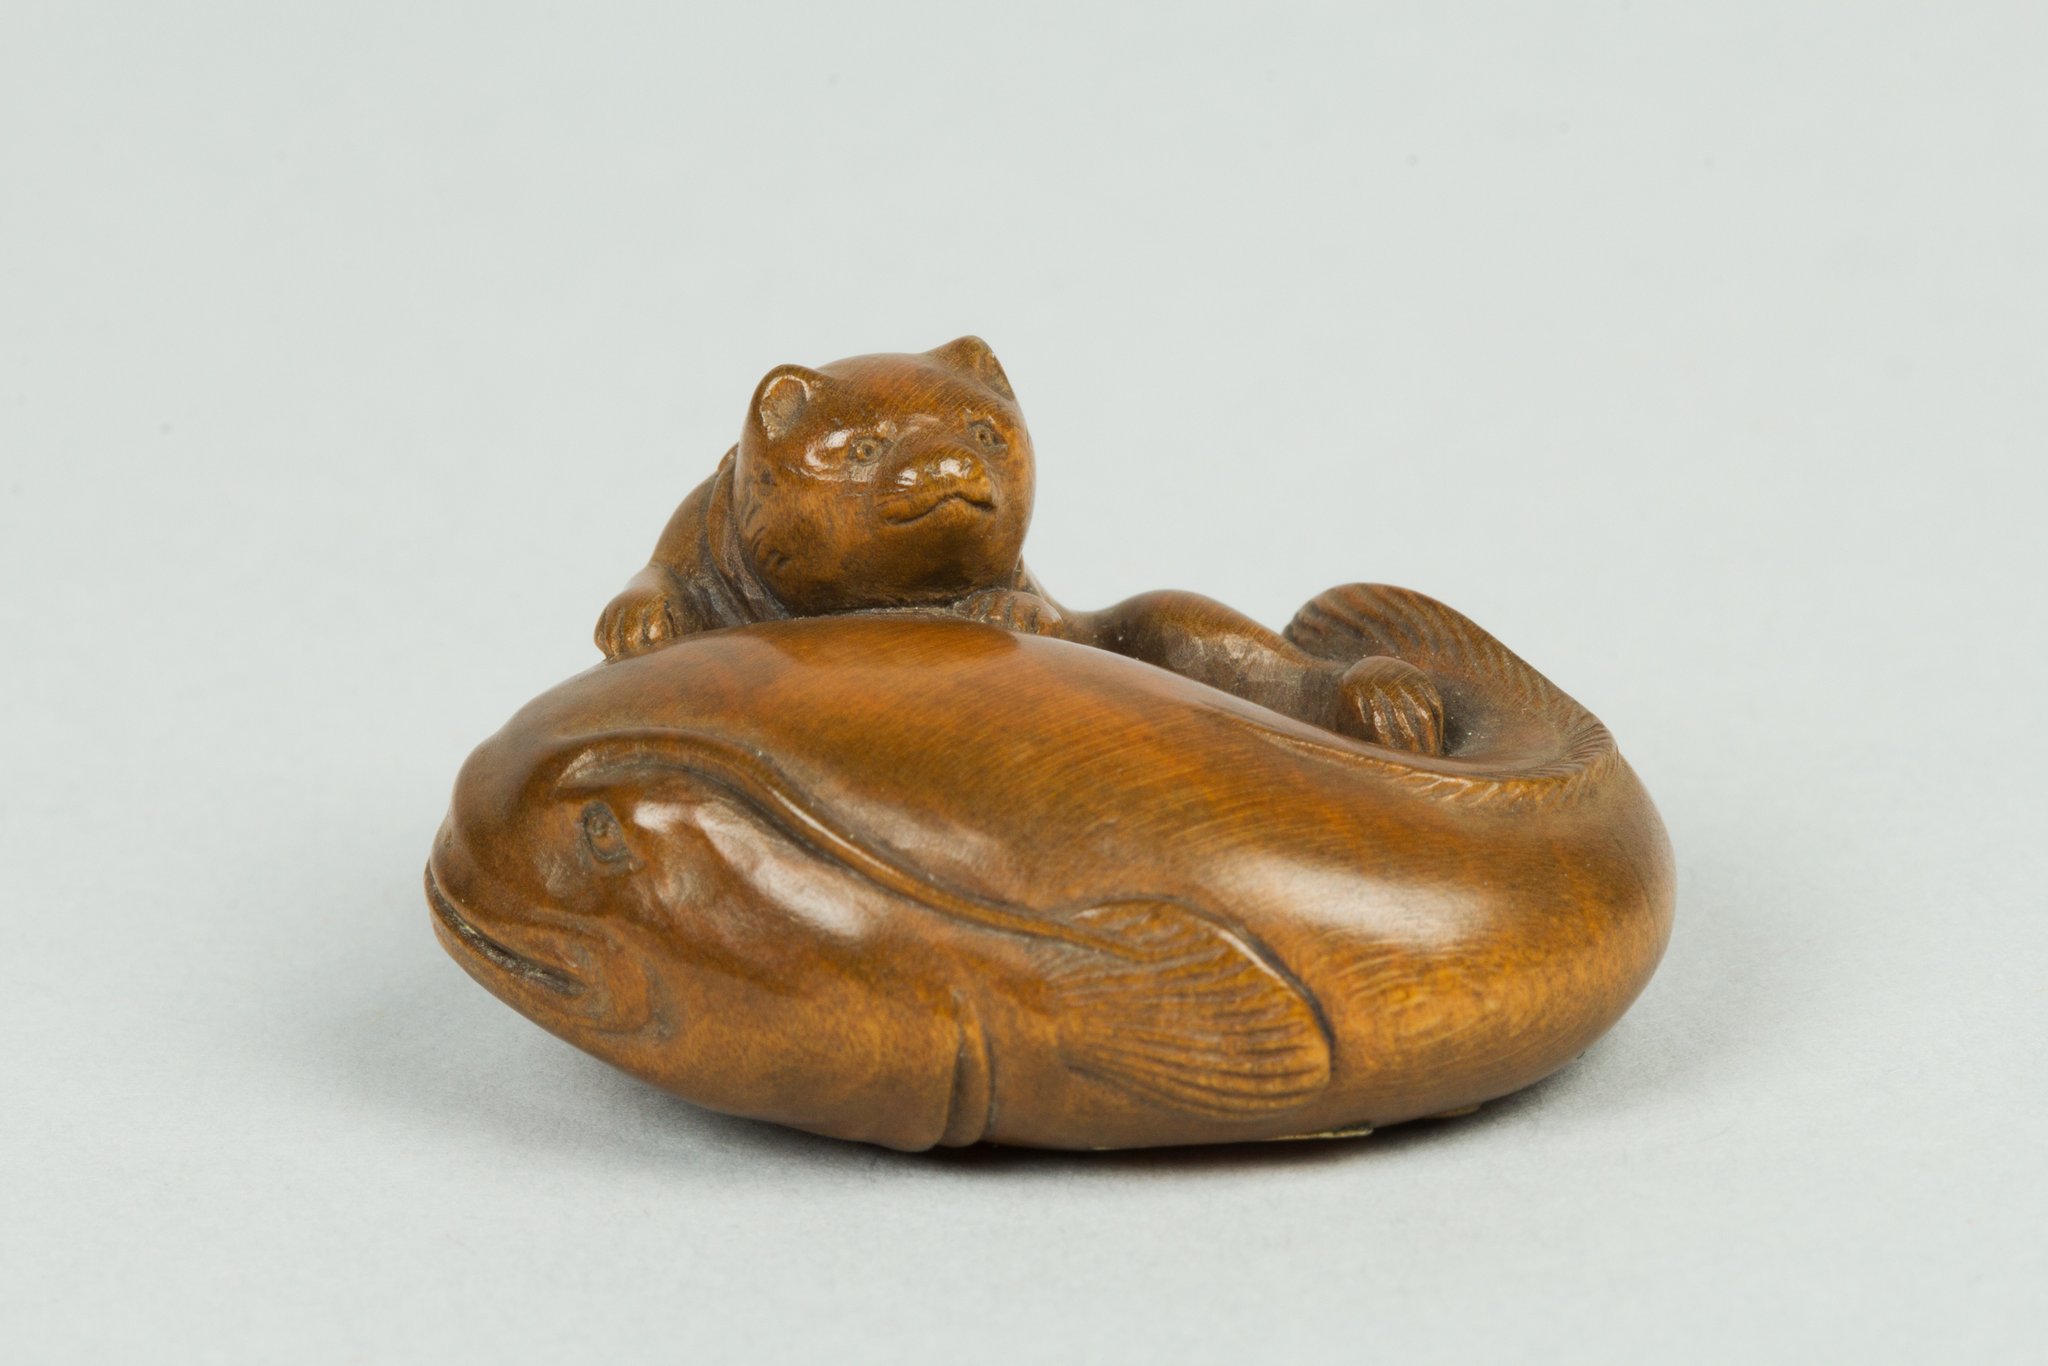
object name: netsuke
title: Netsuke of Carp and Cat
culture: japanese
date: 1801-1900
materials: wood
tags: cats,fish